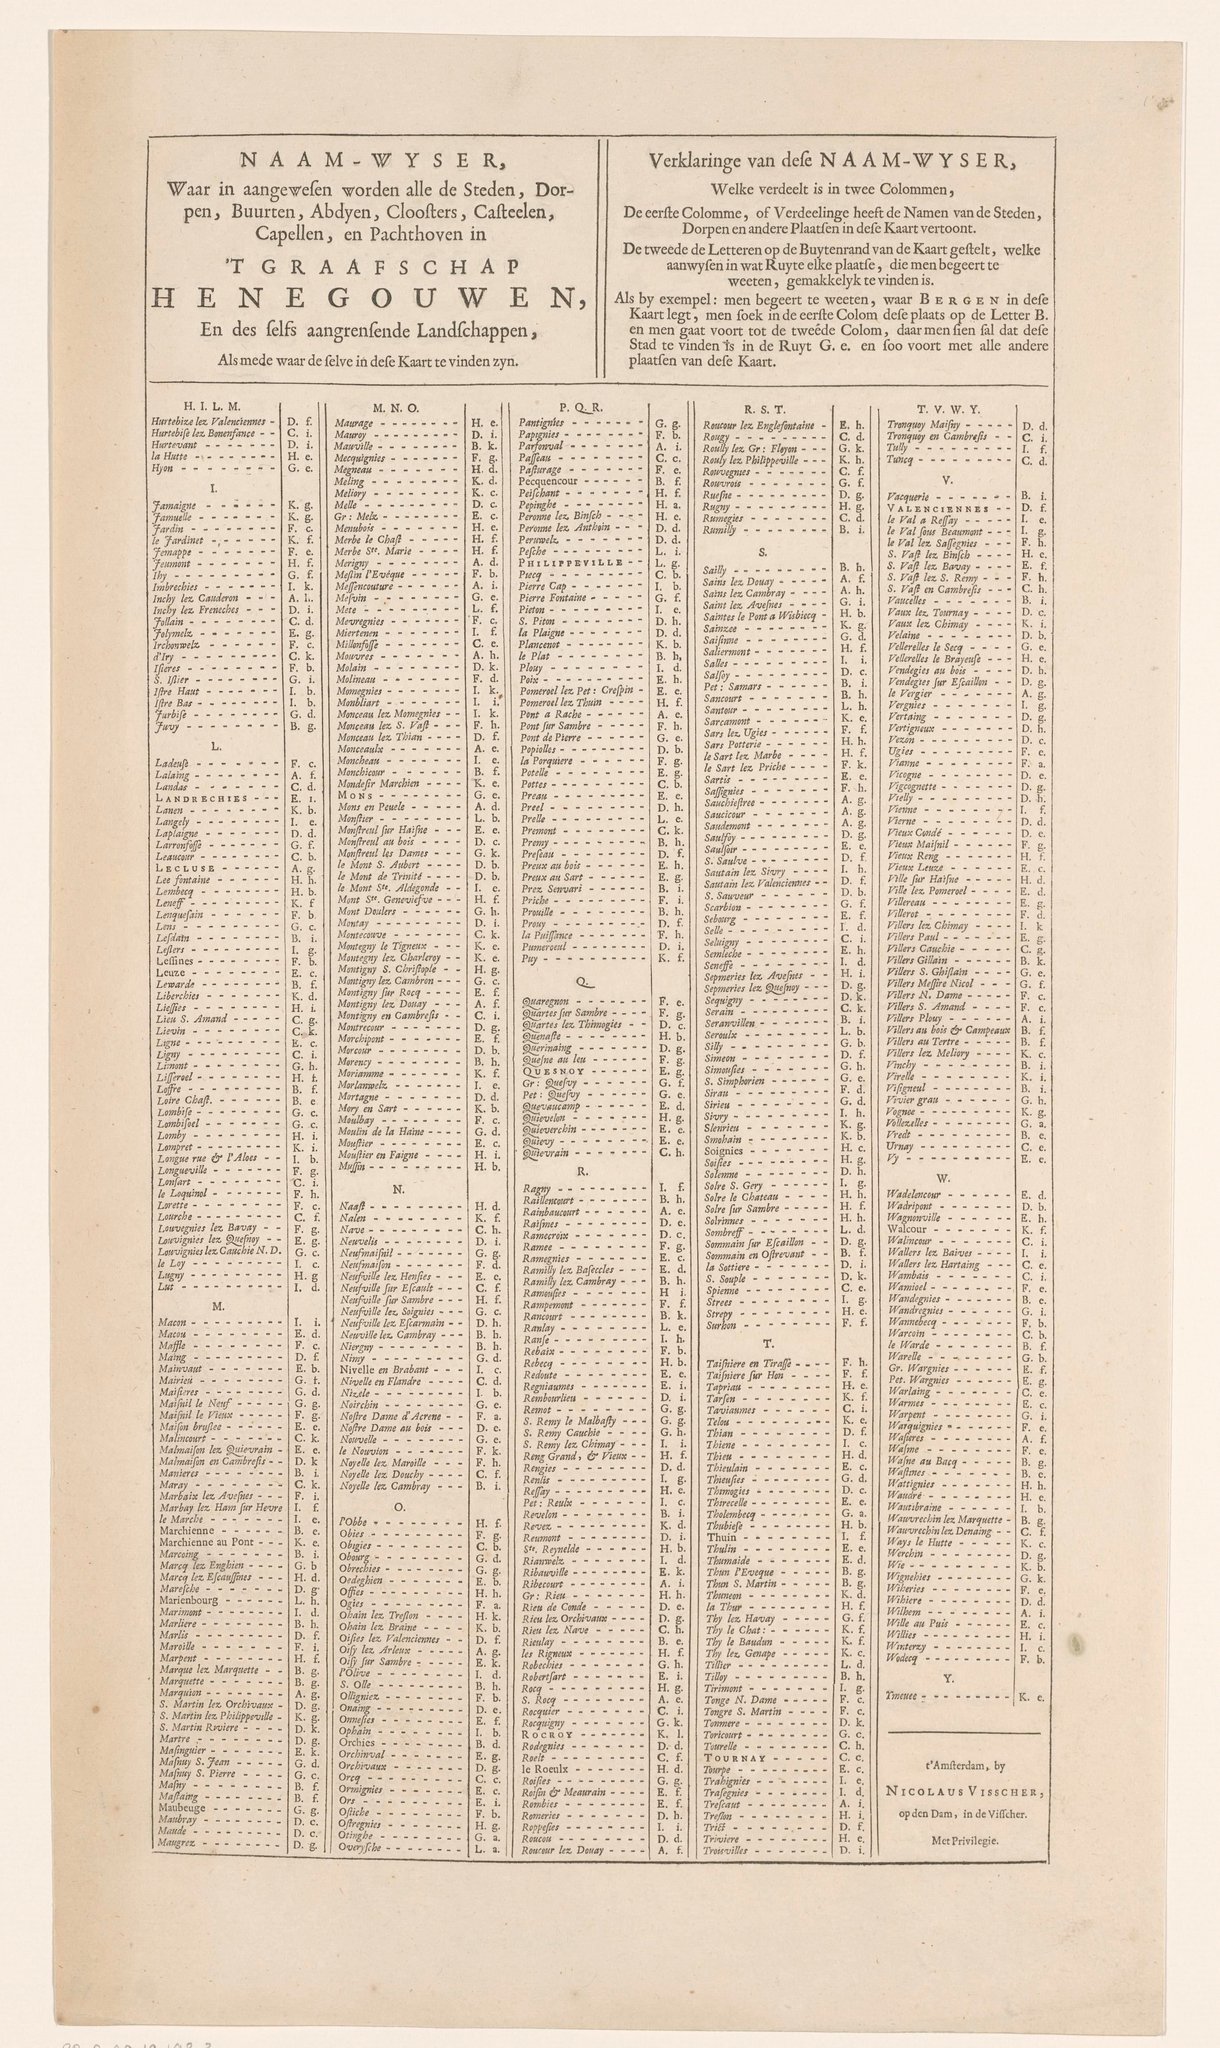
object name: text sheet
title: Plaatsregister van alle dorpen en steden te vinden op de bijhorende kaart (rechterblad)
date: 1677-1720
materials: paper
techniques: letterpress printing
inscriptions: collector's mark: Lugt 2228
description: Rechterblad van het plaatsregister van alle dorpen en steden die te vinden zijn op de bijhorende kaart. Naast de plaatsnamen staat aangegeven waar de plaatsen met behulp van het zoekrooster op de kaart gevonden kunnen worden.